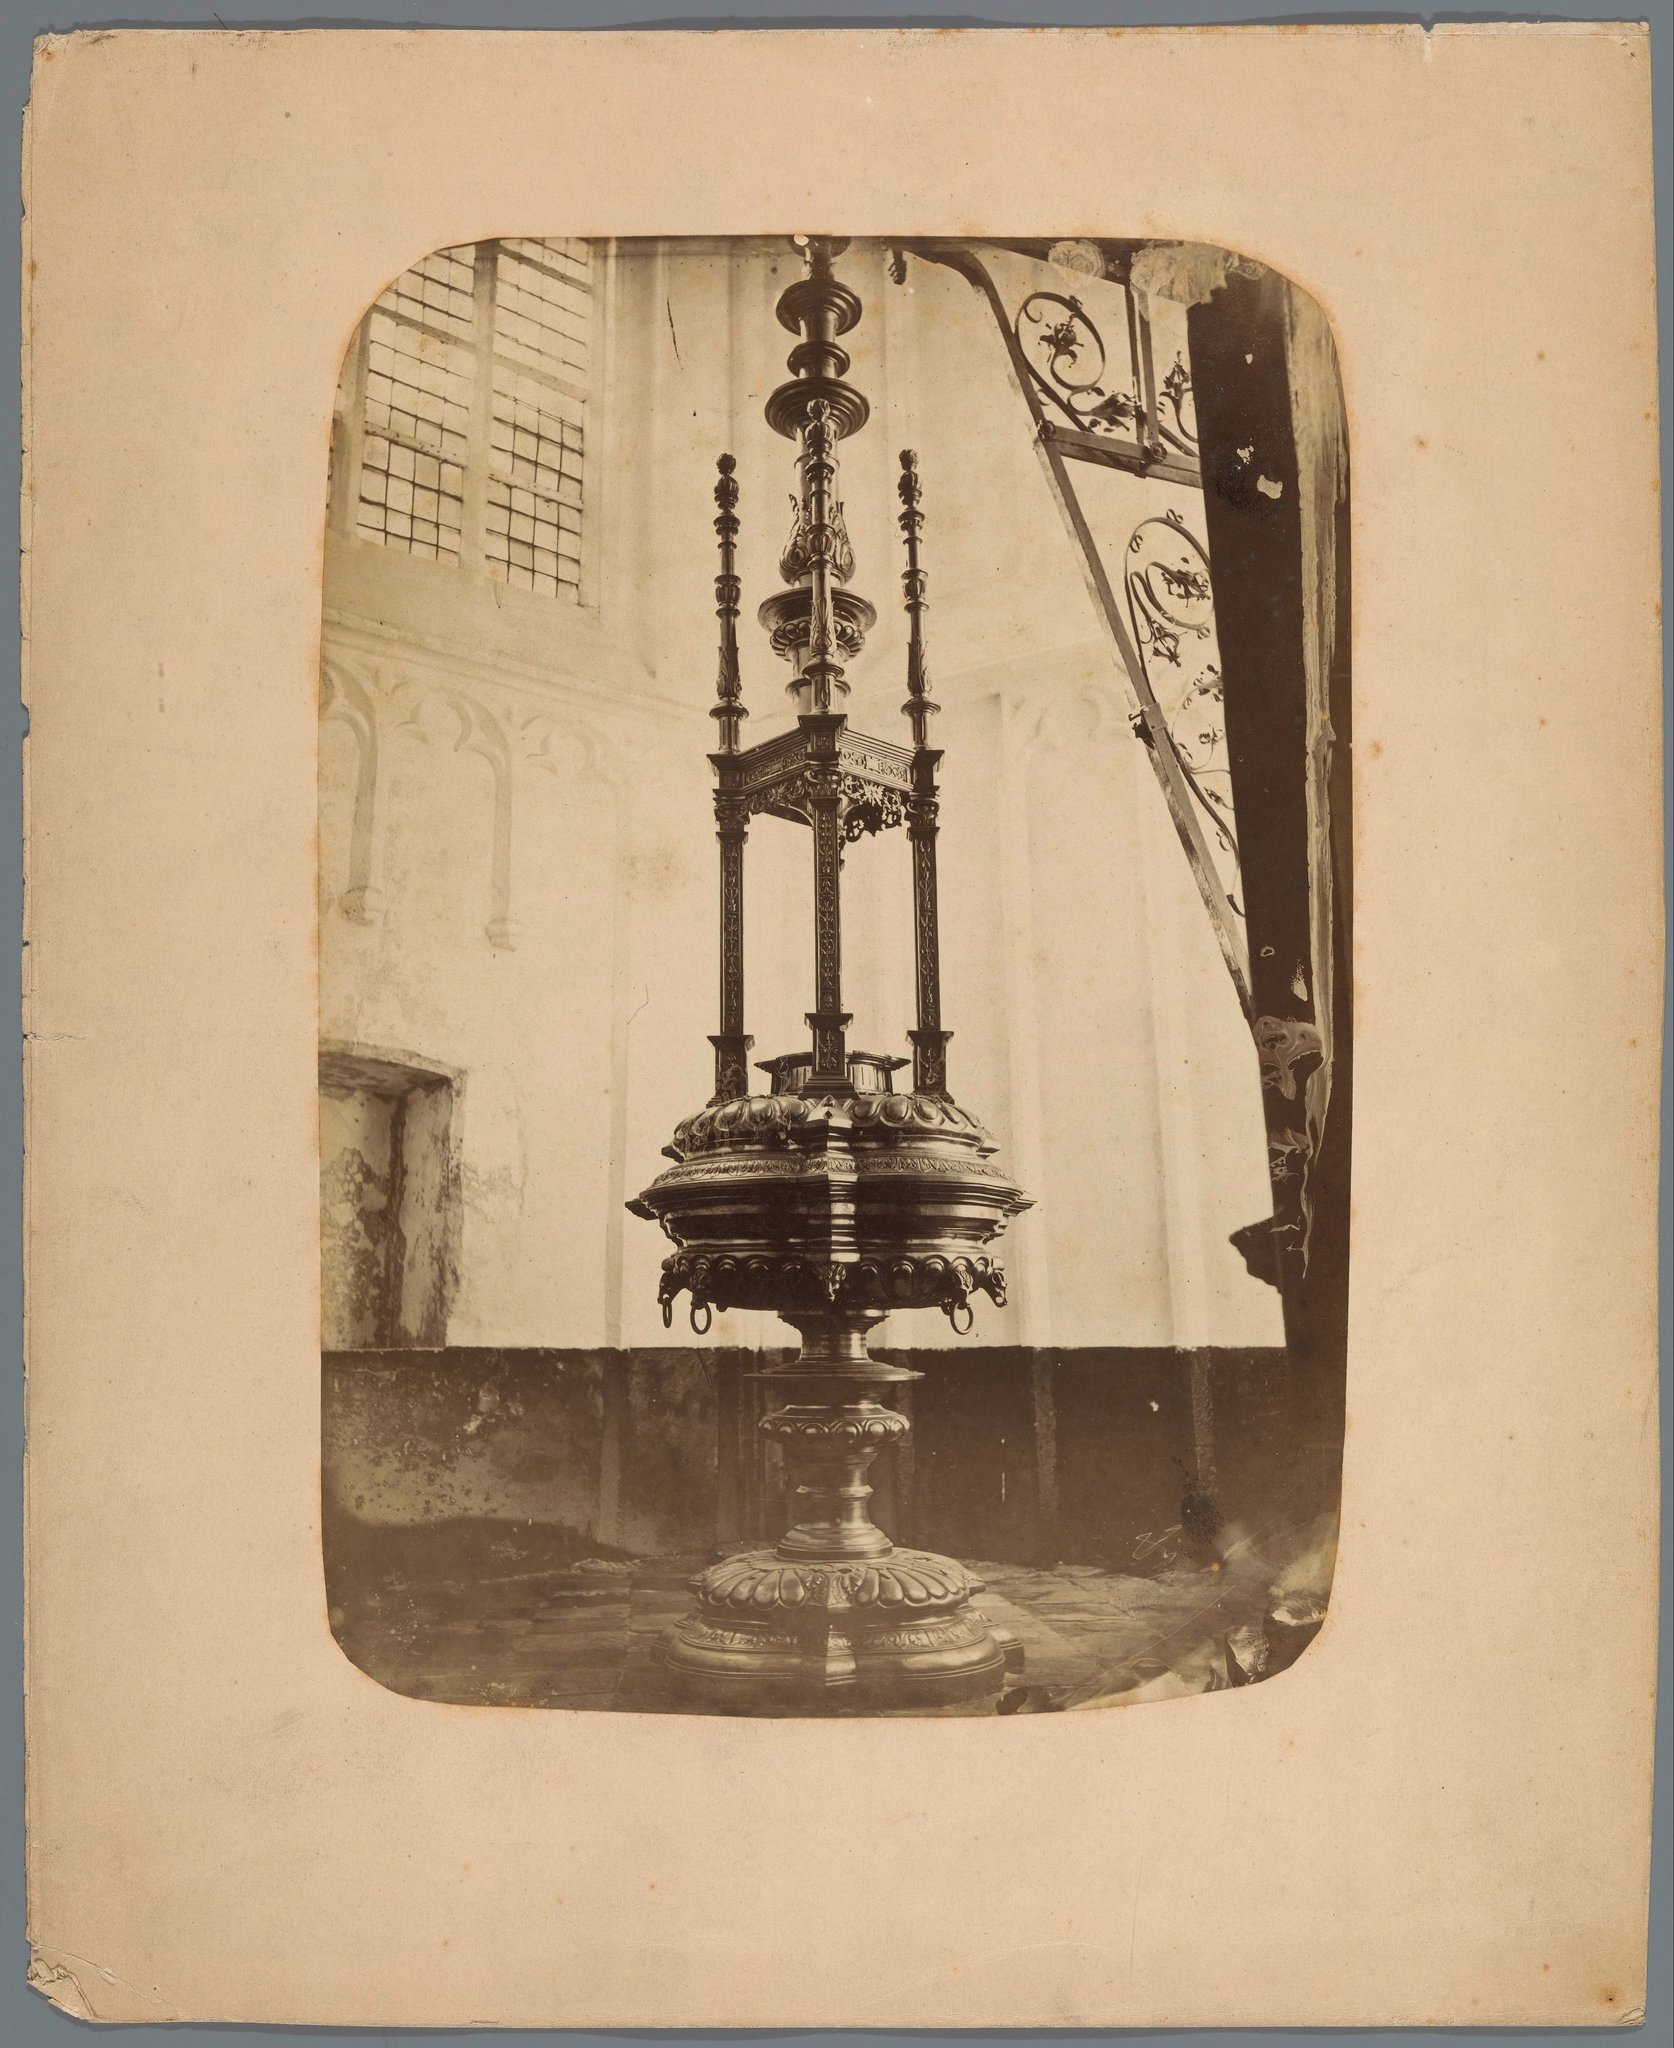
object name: photograph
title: Doopvont in een kerk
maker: Anonymous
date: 1875-1900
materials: cardboard, photographic support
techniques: albumen print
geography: europe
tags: interior of church, baptismal font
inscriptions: name: ‘S. FRANCO, b. i. den Haag.’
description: Messing doopvont in de doopkapel van de Grote Kerk te Breda.